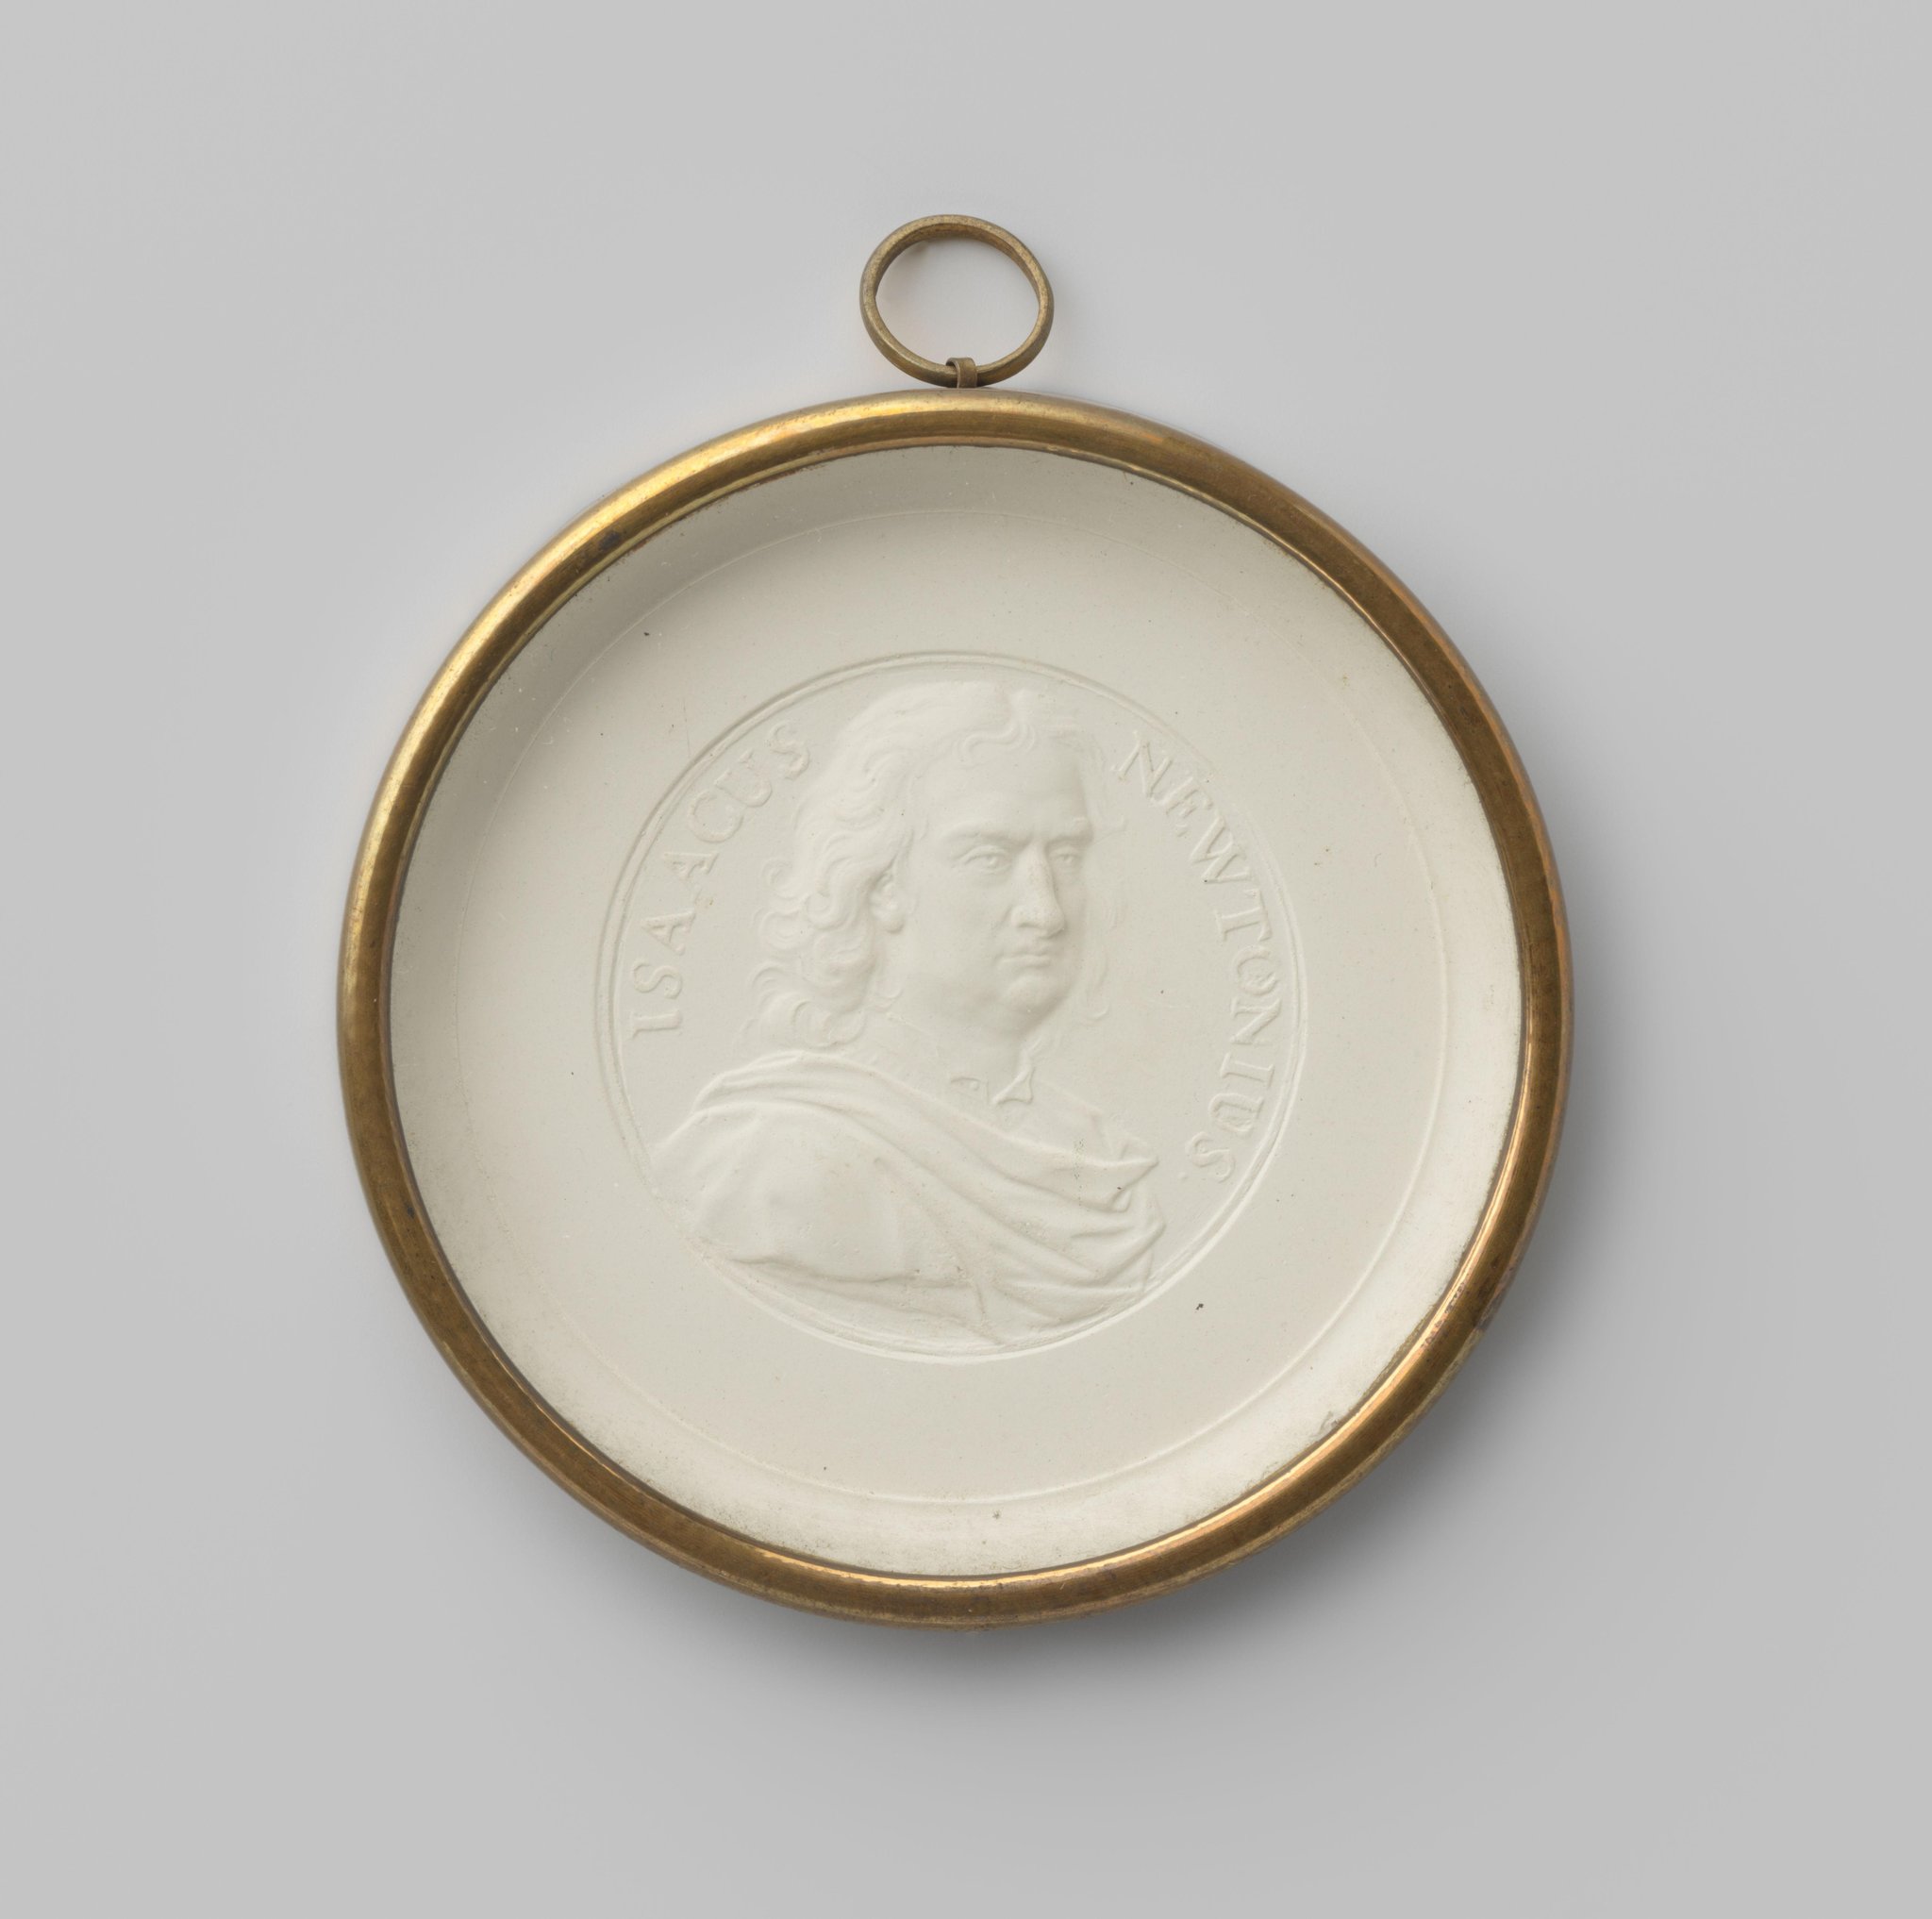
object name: locket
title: Sir Isaac Newton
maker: gottfried eichler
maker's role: draughtsman, painter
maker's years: 1677-1757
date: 1687-1757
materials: brass, glass, gypsum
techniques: casting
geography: berlin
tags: london, physicist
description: Eenzijdig medaillon in messing ring achter glas aan draagoog en draagring. Voorzijde: borststuk man naar rechts binnen omschrift. Keerzijde: etiket met opschrift.